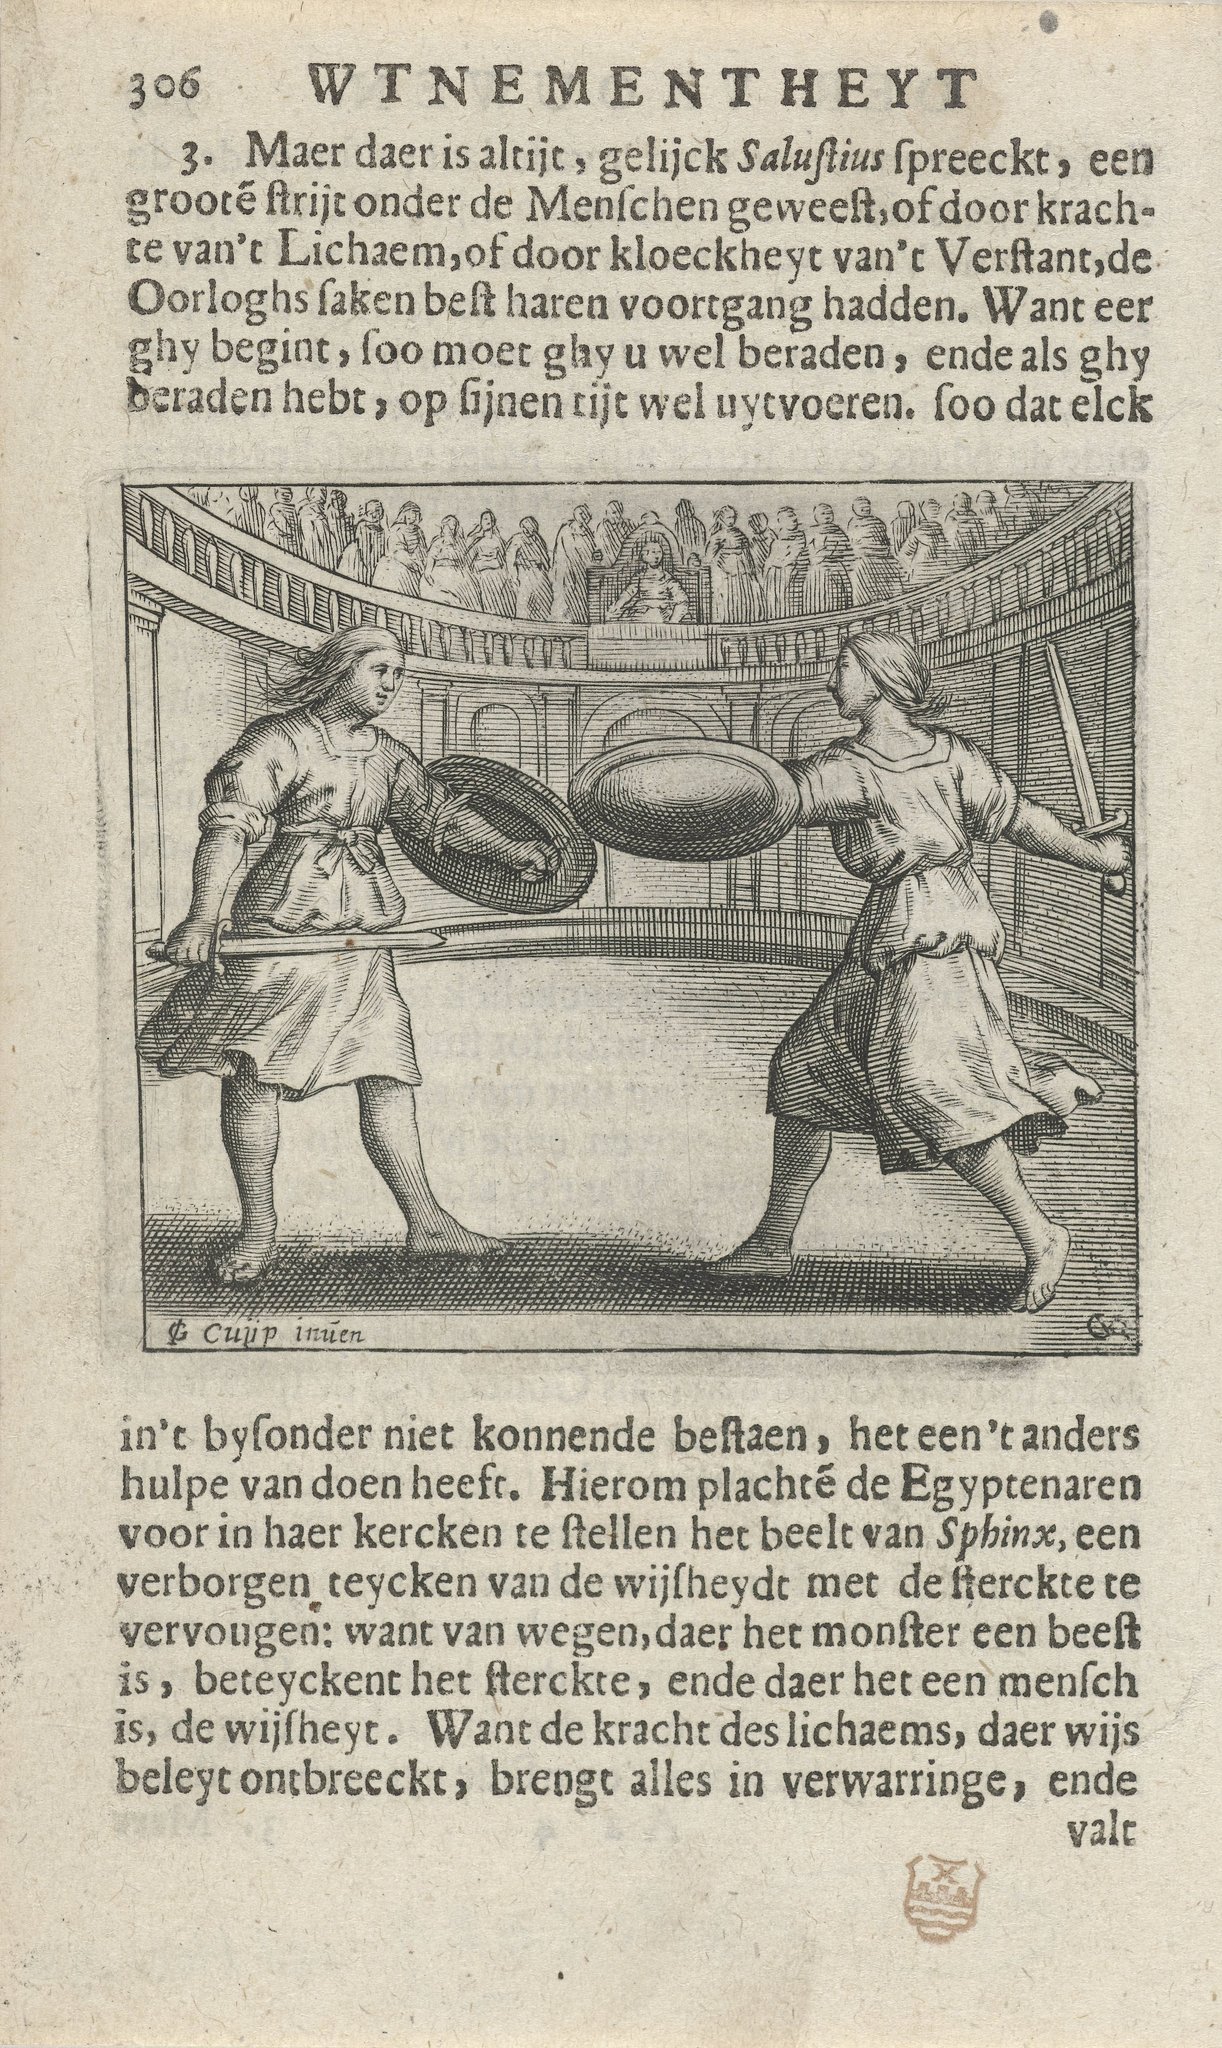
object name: book illustration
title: Twee vechtende vrouwen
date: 1643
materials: paper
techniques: engraving, letterpress printing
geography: the hague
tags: fighting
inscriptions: collector's mark: Lugt 2760, collector's mark: Lugt 2228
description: In een arena vechten twee vrouwen tegen elkaar met schild en degen, onder het toeziend oog van publiek. Bladzijde uit een boek met tekst op recto en verso.